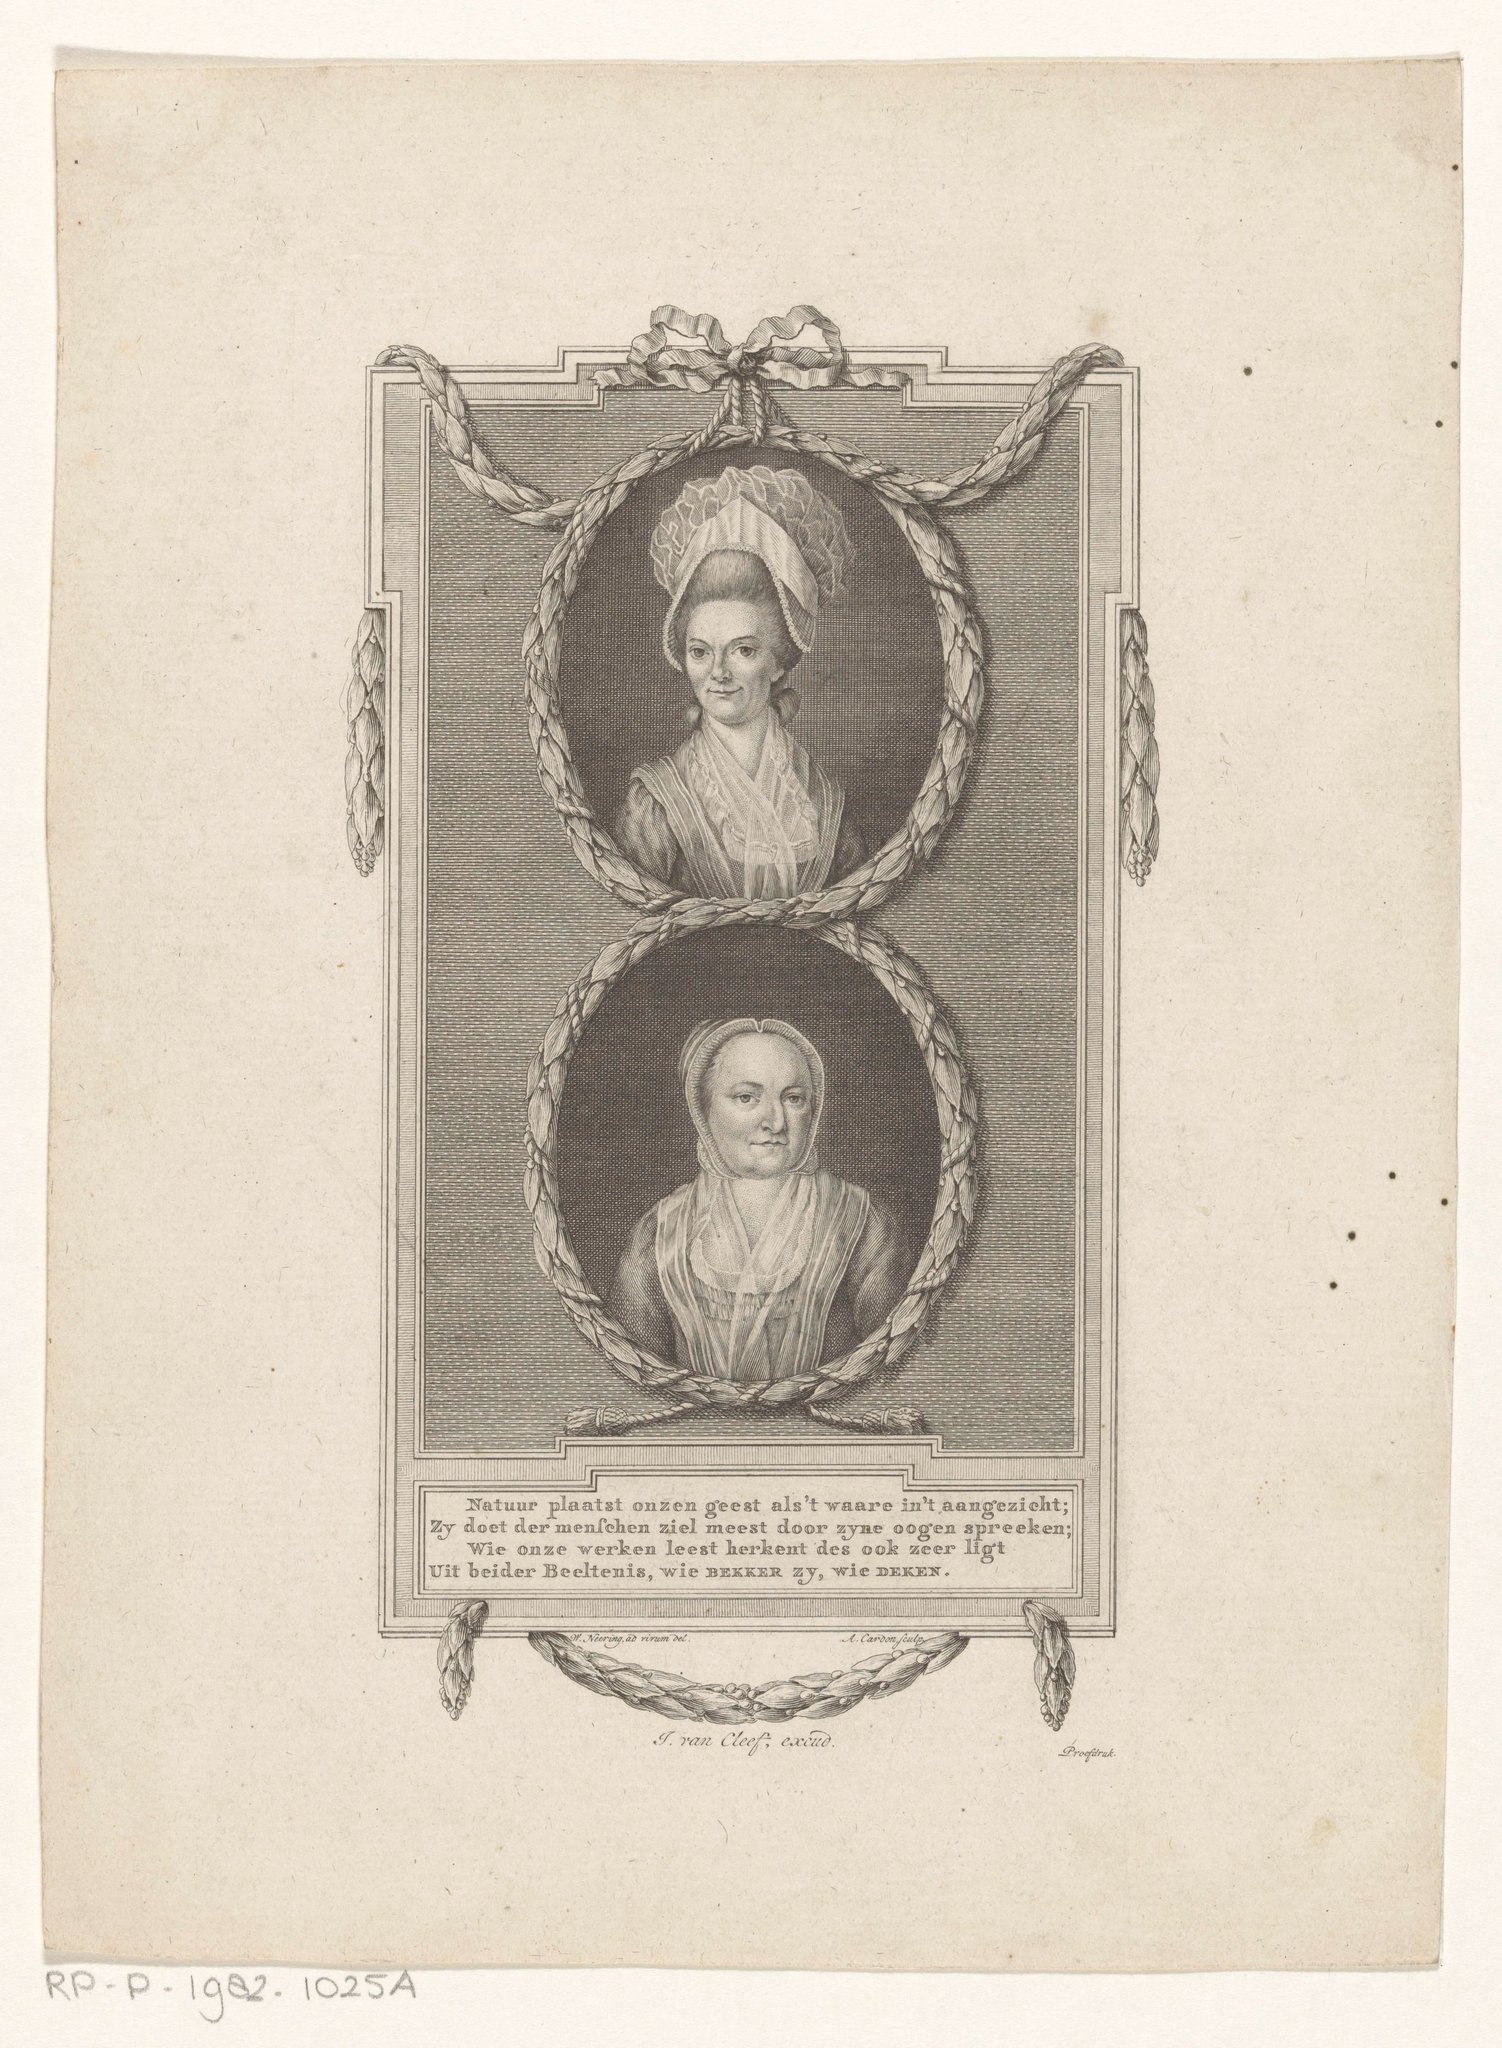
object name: print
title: Dubbelportret van Elisabeth Bekker en Agatha Deken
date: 1784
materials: paper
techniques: etching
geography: the hague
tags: elisabeth bekker, the hague, agatha deken, portrait of a writer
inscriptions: collector's mark: Lugt 2228, collector's mark: Lugt 2760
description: Portretten van de twee schrijfsters in medaillons met lauwerkransen. Onder de portretten een tekst op de schrijfsters.